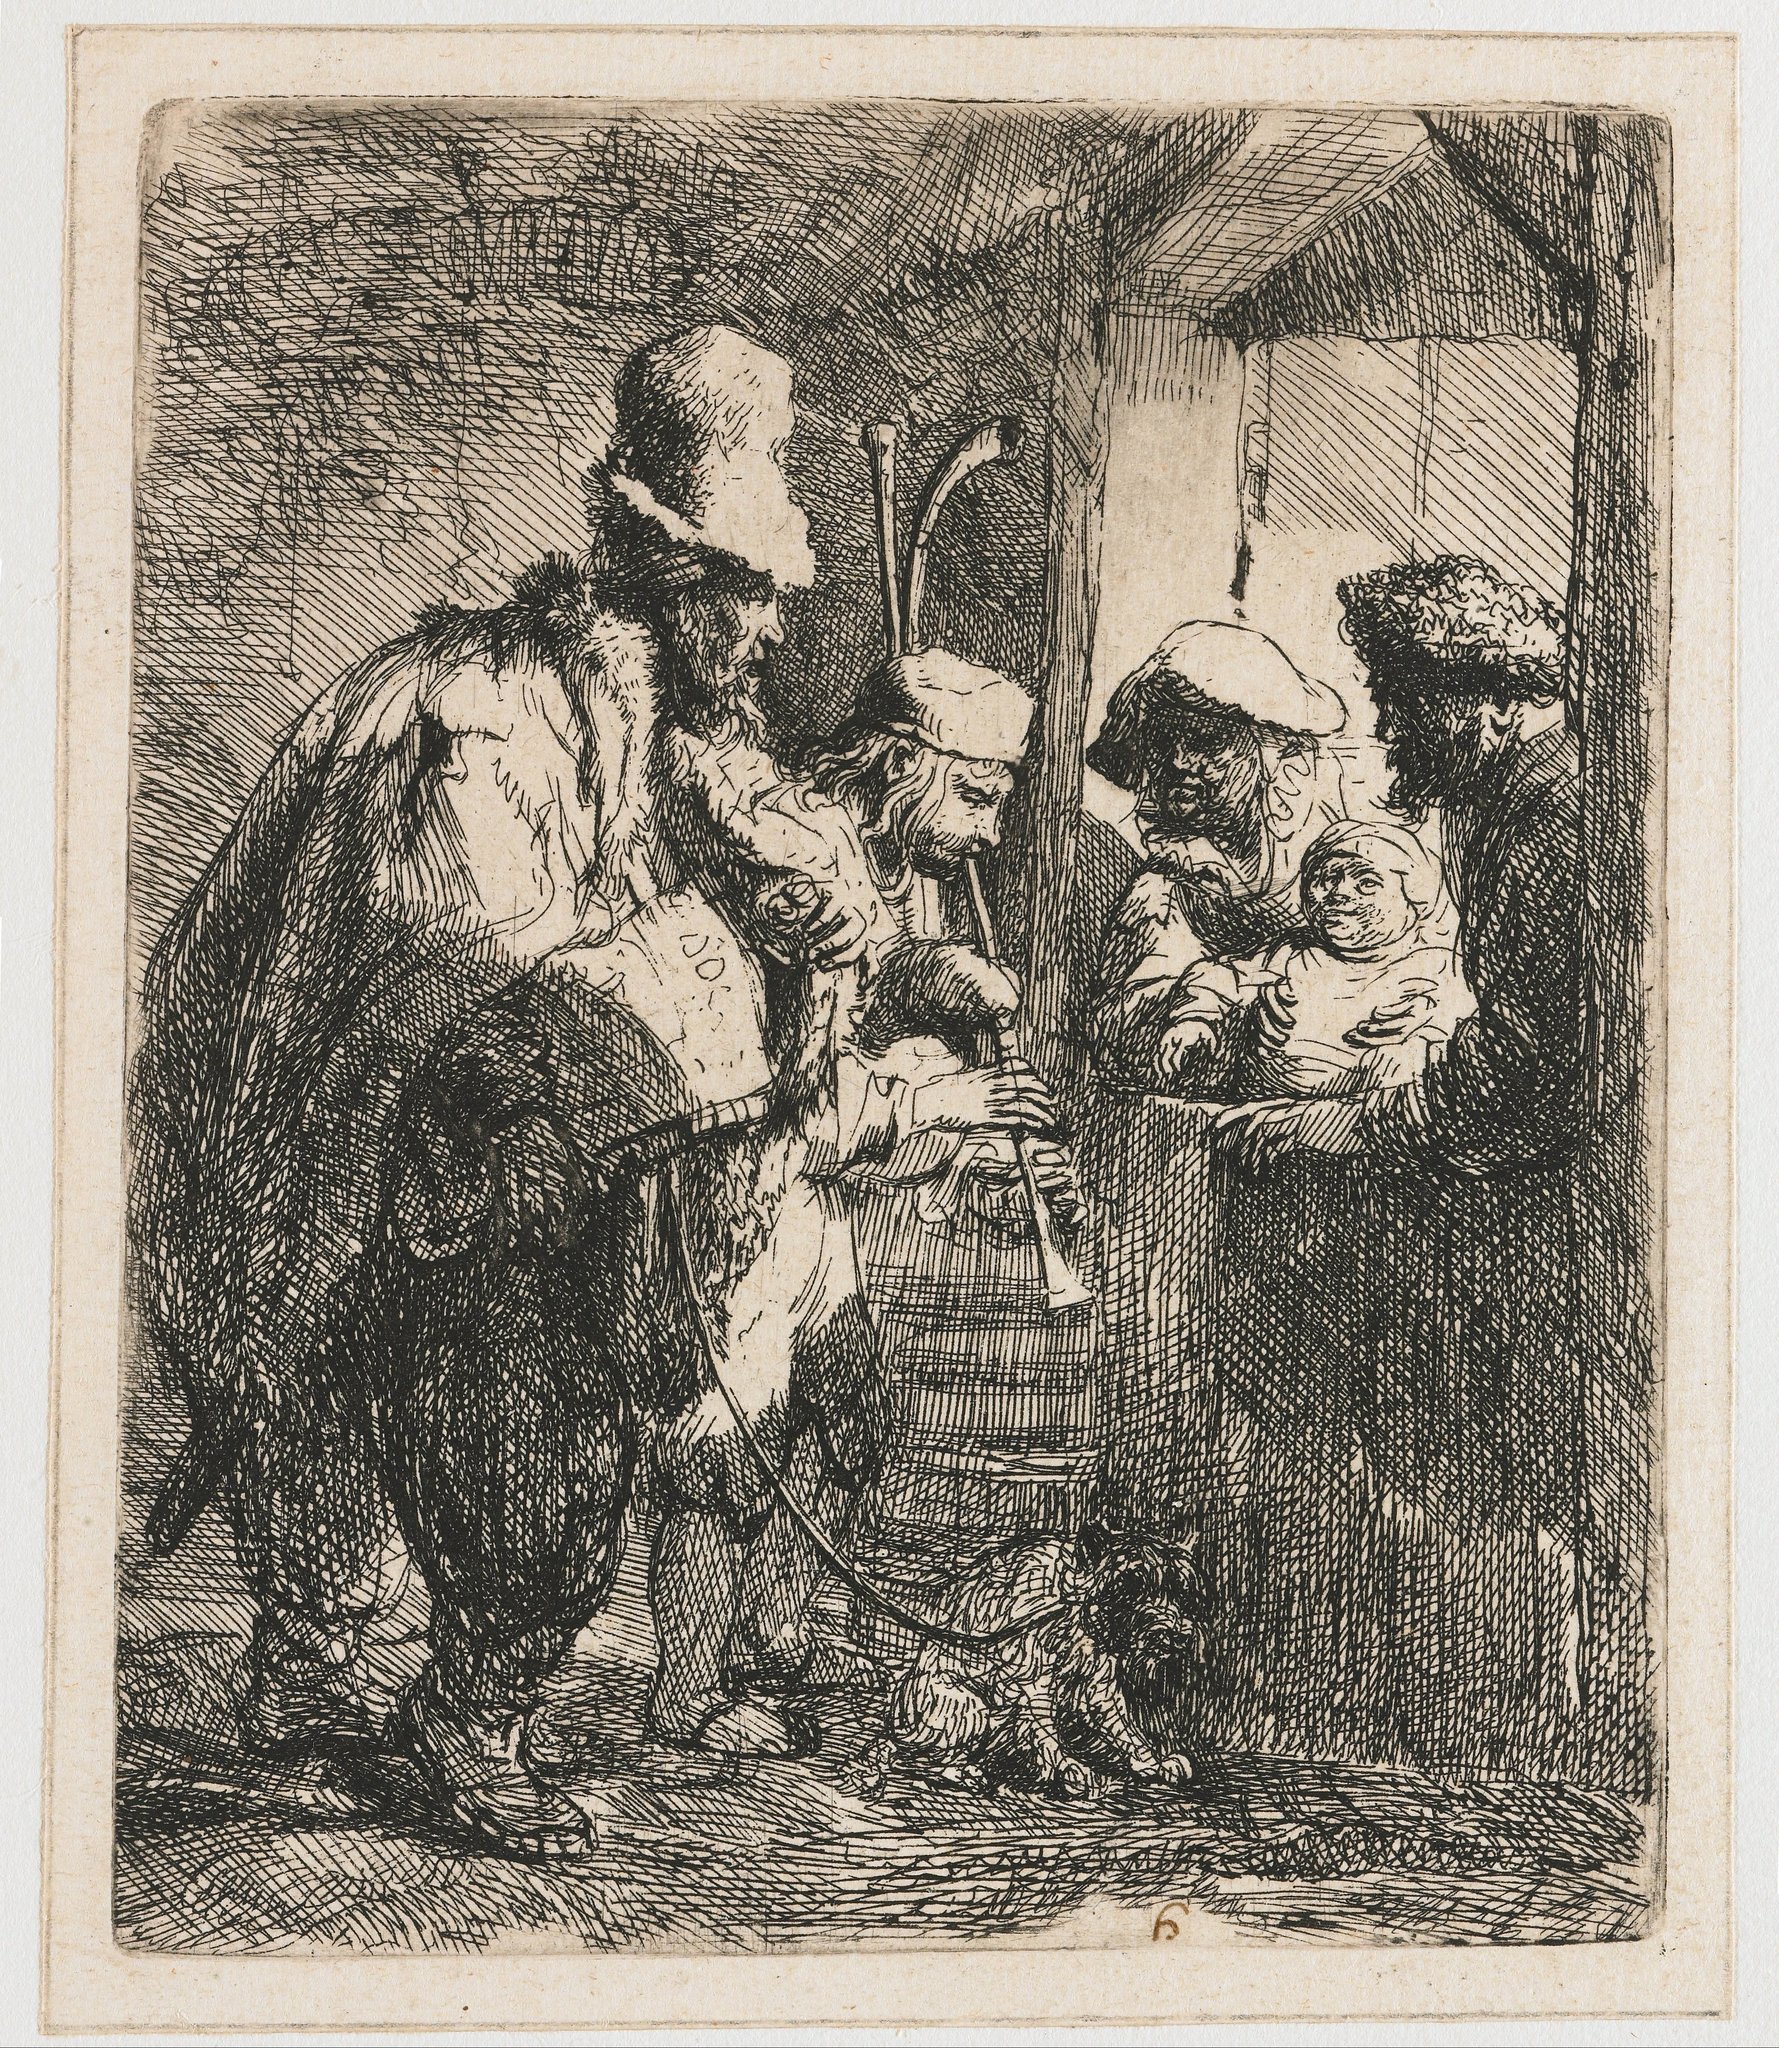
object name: print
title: The strolling musicians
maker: rembrandt van rijn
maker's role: draughtsman, painter, print maker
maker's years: 1606-1669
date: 1635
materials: paper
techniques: etching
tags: more than one musician with instrument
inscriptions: collector's mark: Lugt 240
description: Music echoes in all of these street scenes. Three prints show a hurdy-gurdy player accompanied by his family or followed by a crush of children going door to door to play a tune and ask for alms. Often these musicians were blind and hence had a guide dog, as seen in the print at the upper left. There the child in the doorway beams with delight.